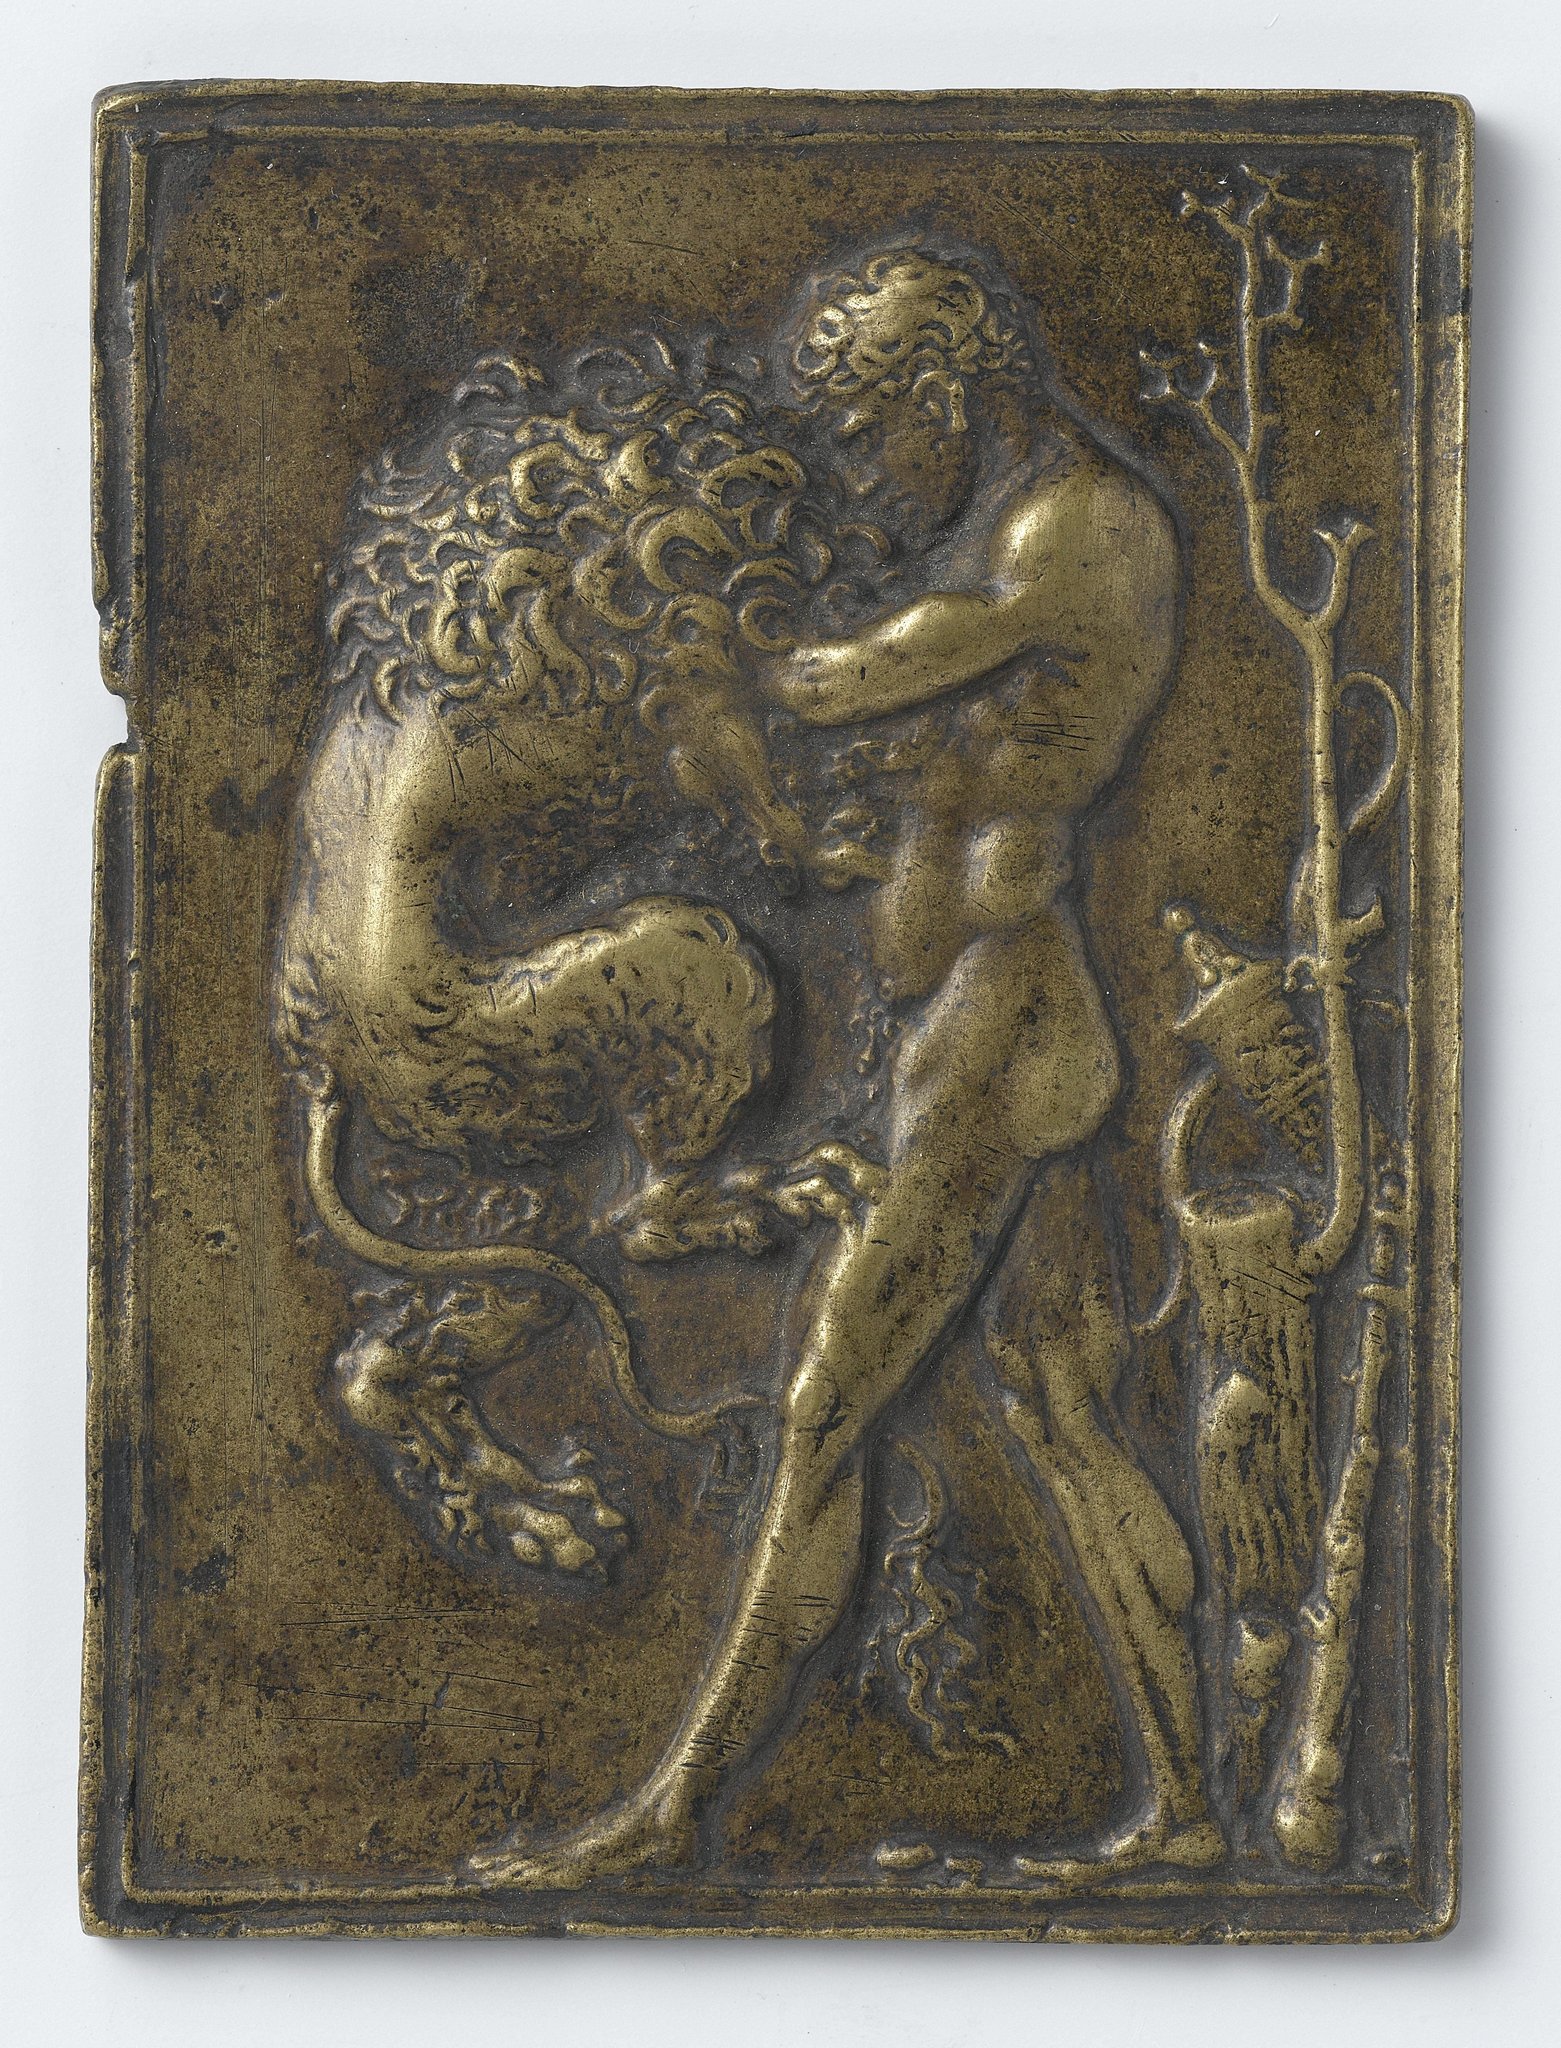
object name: sculpture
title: Hercules, de Nemische leeuw wurgend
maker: moderno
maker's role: jeweler, sculptor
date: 1500-1525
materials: bronze